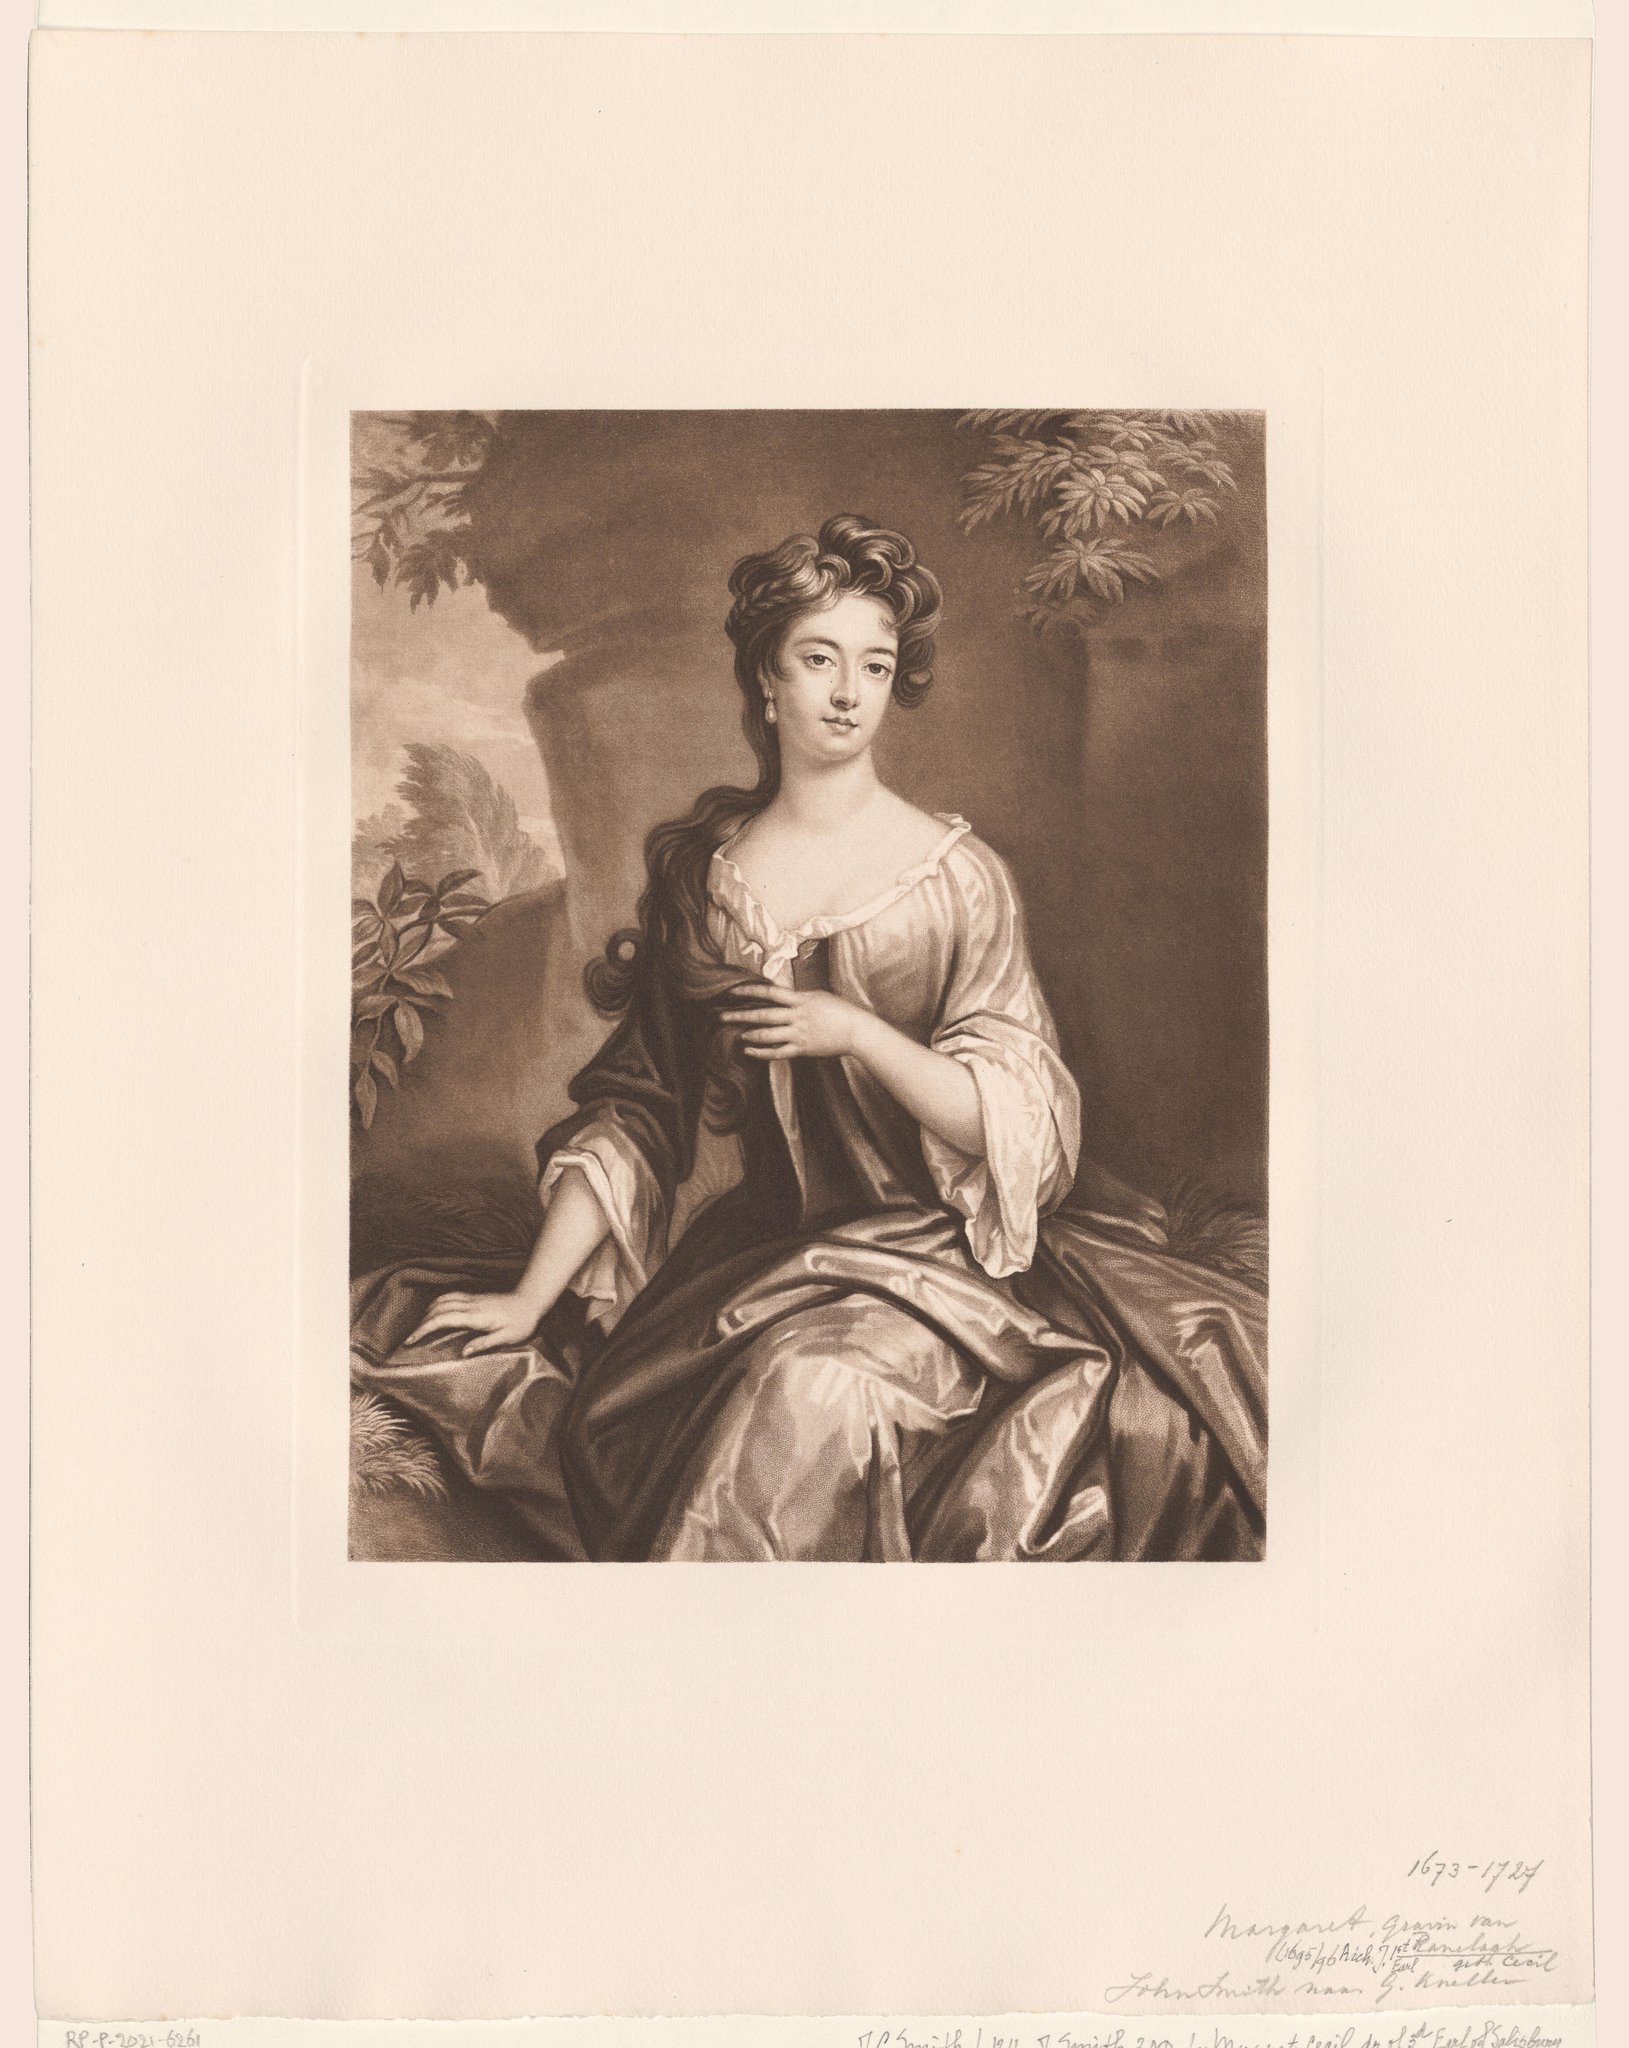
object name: photomechanical print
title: Portret van Margaret Cecil, hertogin van Ranelagh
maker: Anonymous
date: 1870-1915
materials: paper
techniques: photoaquatint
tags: historical persons